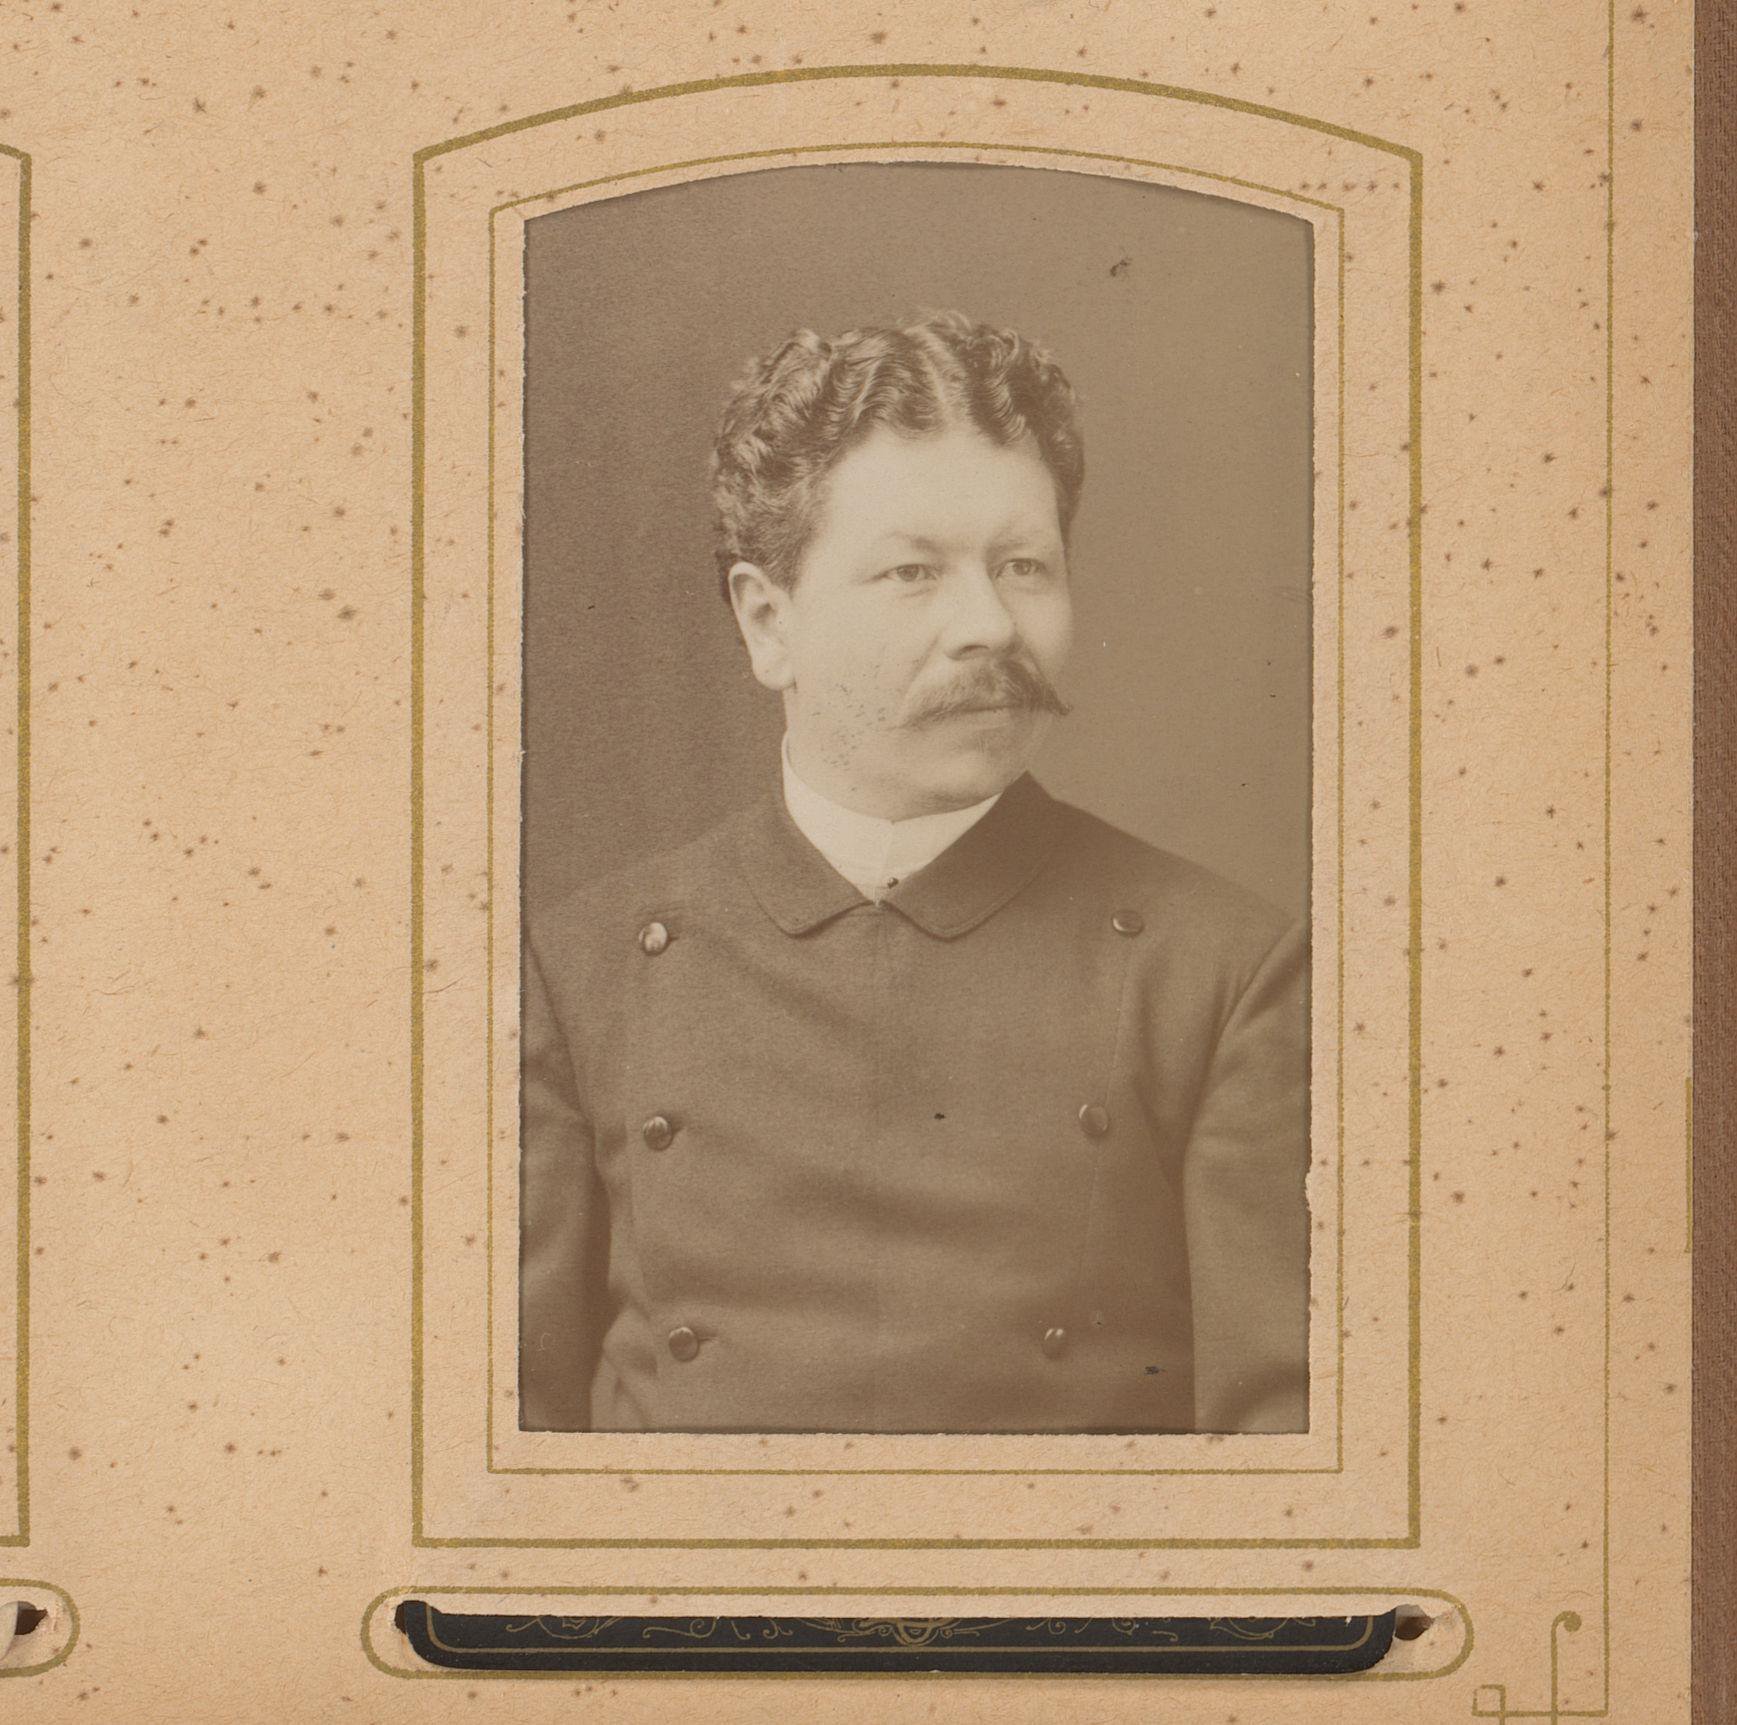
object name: album leaf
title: Portret van een man met snor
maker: ernst schroeter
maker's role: fotograaf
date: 1860-1900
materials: cardboard, photographic support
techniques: albumen print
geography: meissen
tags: moustache, historical persons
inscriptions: inscription: ‘ERNST SCHROETER/ Photographisches Atelier/ 597. OBERGASSE 597./ MEISSEN.’